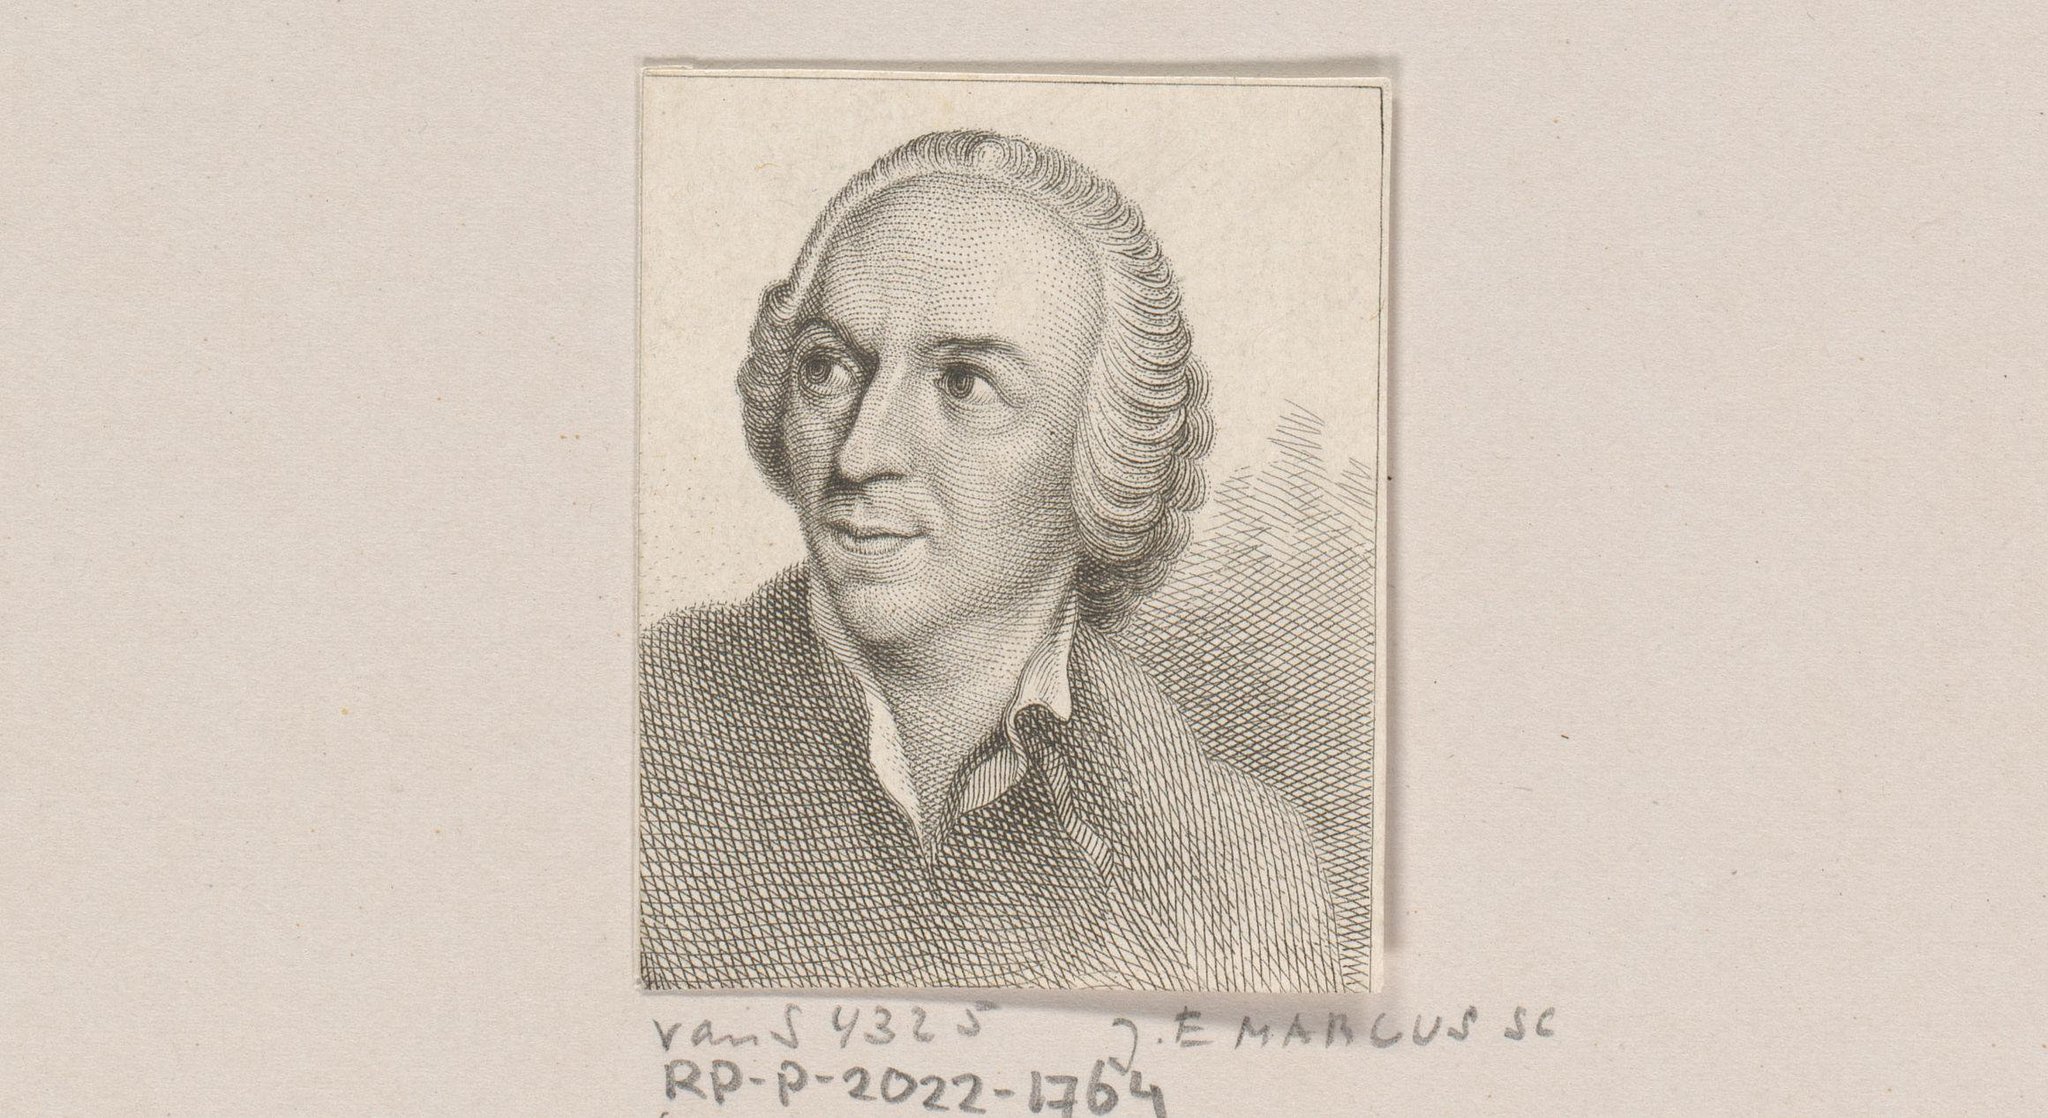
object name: print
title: Portret van Jan Punt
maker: jacob ernst marcus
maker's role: draughtsman, print maker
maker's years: 1774-1826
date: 1817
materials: paper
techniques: etching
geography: amsterdam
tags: amsterdam, print maker, draughtsman, publisher, jan punt, historical persons, portrait, self-portrait of artist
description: Volledige prent waarschijnlijk uit: Eynden, Roeland van en Adriaan van der Willigen. Geschiedenis der vaderlansche schilderkunst, sedert de helft der XVIII eeuw. Haarlem: A. Loosjes, Pz [vanaf dl 3: Wed. A. Loosjes], 4 dln., 1816-40.